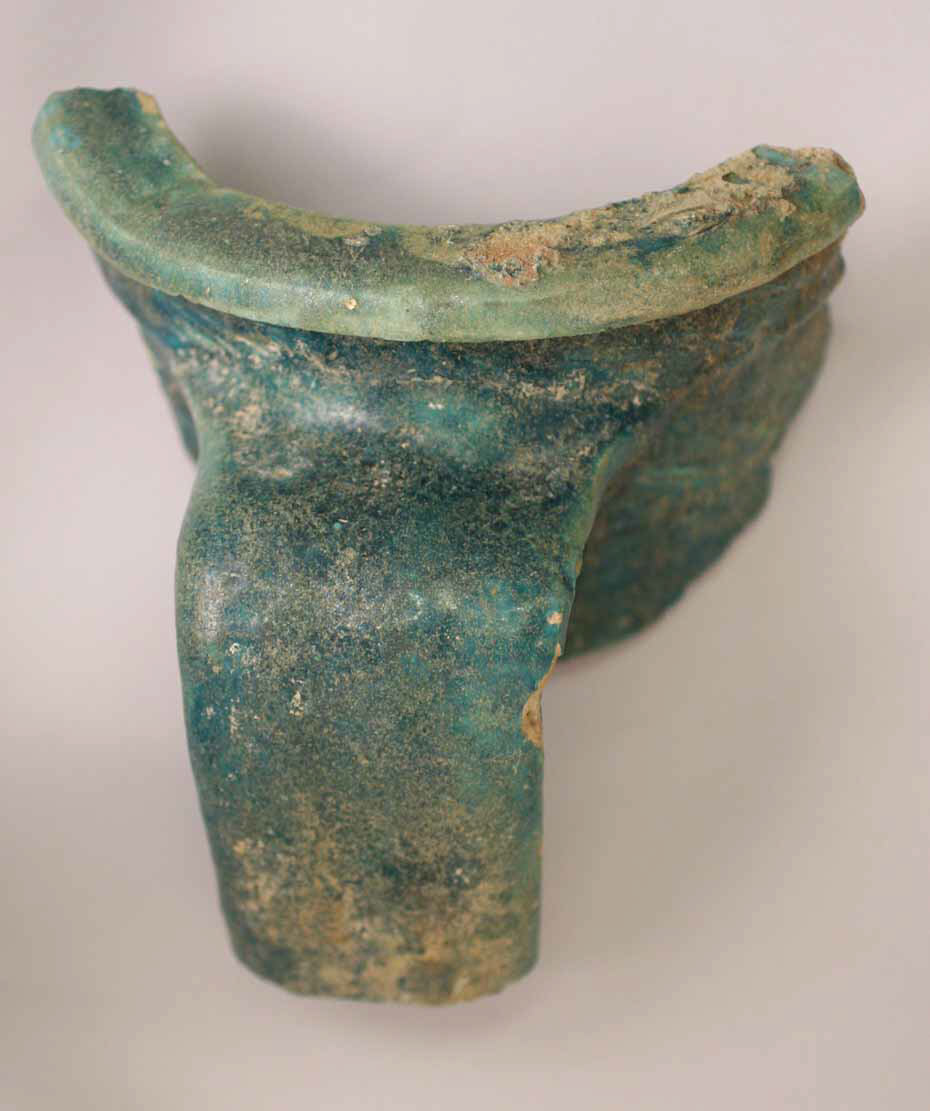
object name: fragment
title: Ceramic Fragment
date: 601-800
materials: earthenware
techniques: glazing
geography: iraq